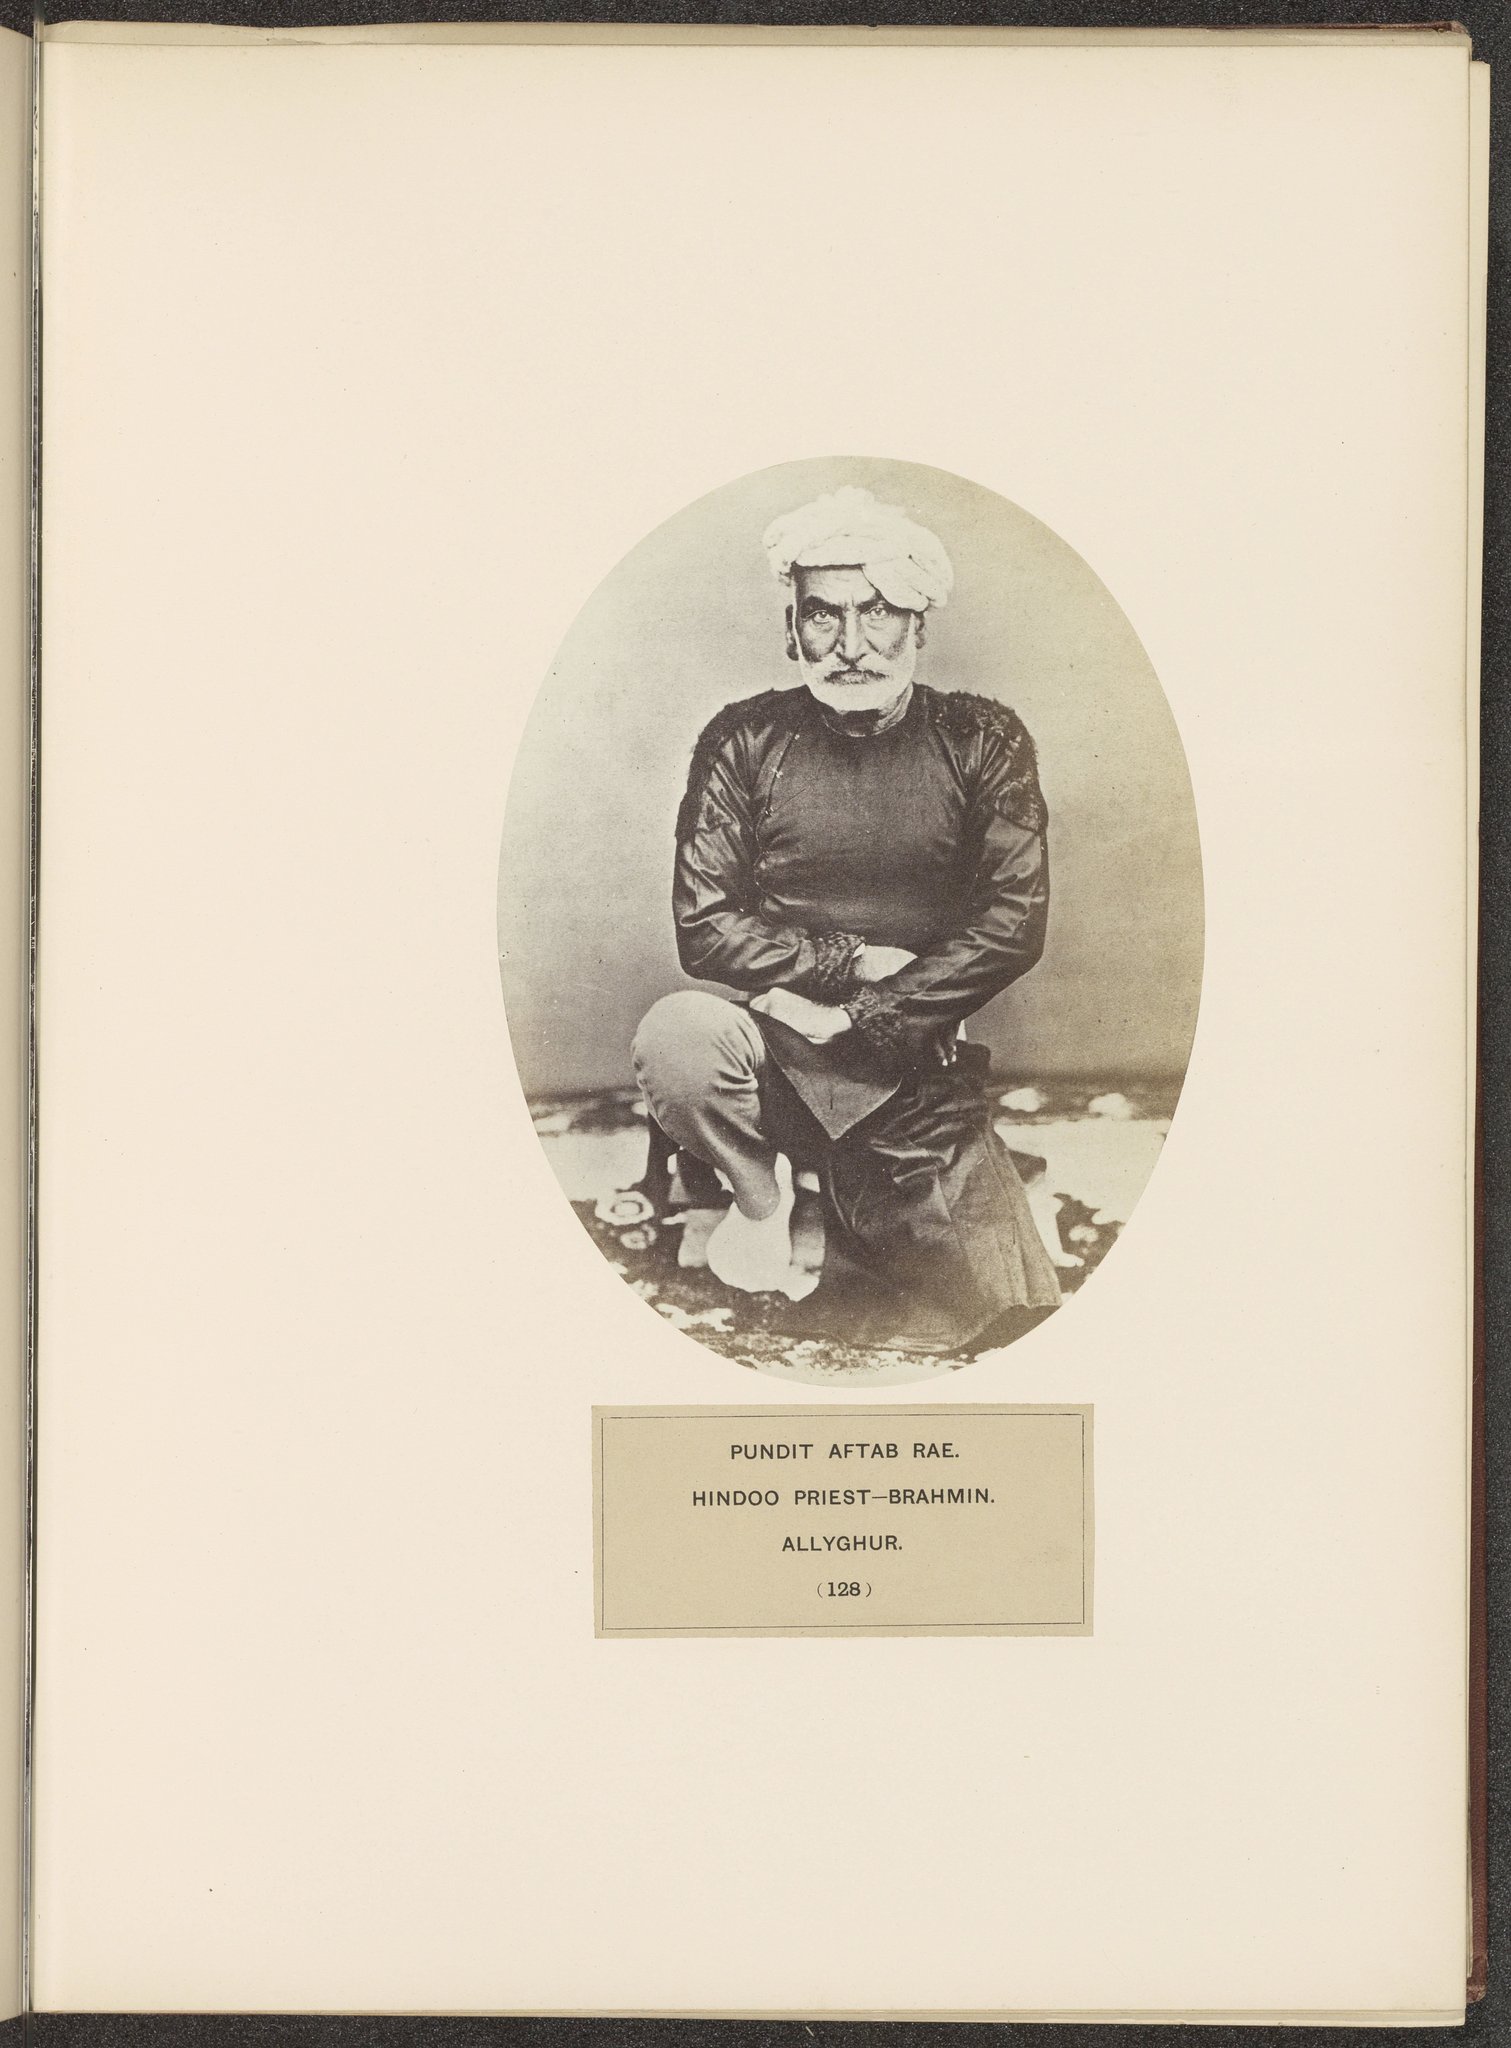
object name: photograph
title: Portrait of a brahmin (Hindu priest) Pundit Aftab Rae from Aligarh, Uttar Pradesh, India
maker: Anonymous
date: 1858-1868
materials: photographic support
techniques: albumen print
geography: aligarh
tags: priest ~ hinduism, buddhism, jainism, human races; peoples; nationalities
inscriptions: number: ‘(128)’, inscription: ‘PUNDIT AFTAB RAE./ HINDOO PRIEST - BRAHMIN./ ALLYGHUR.’